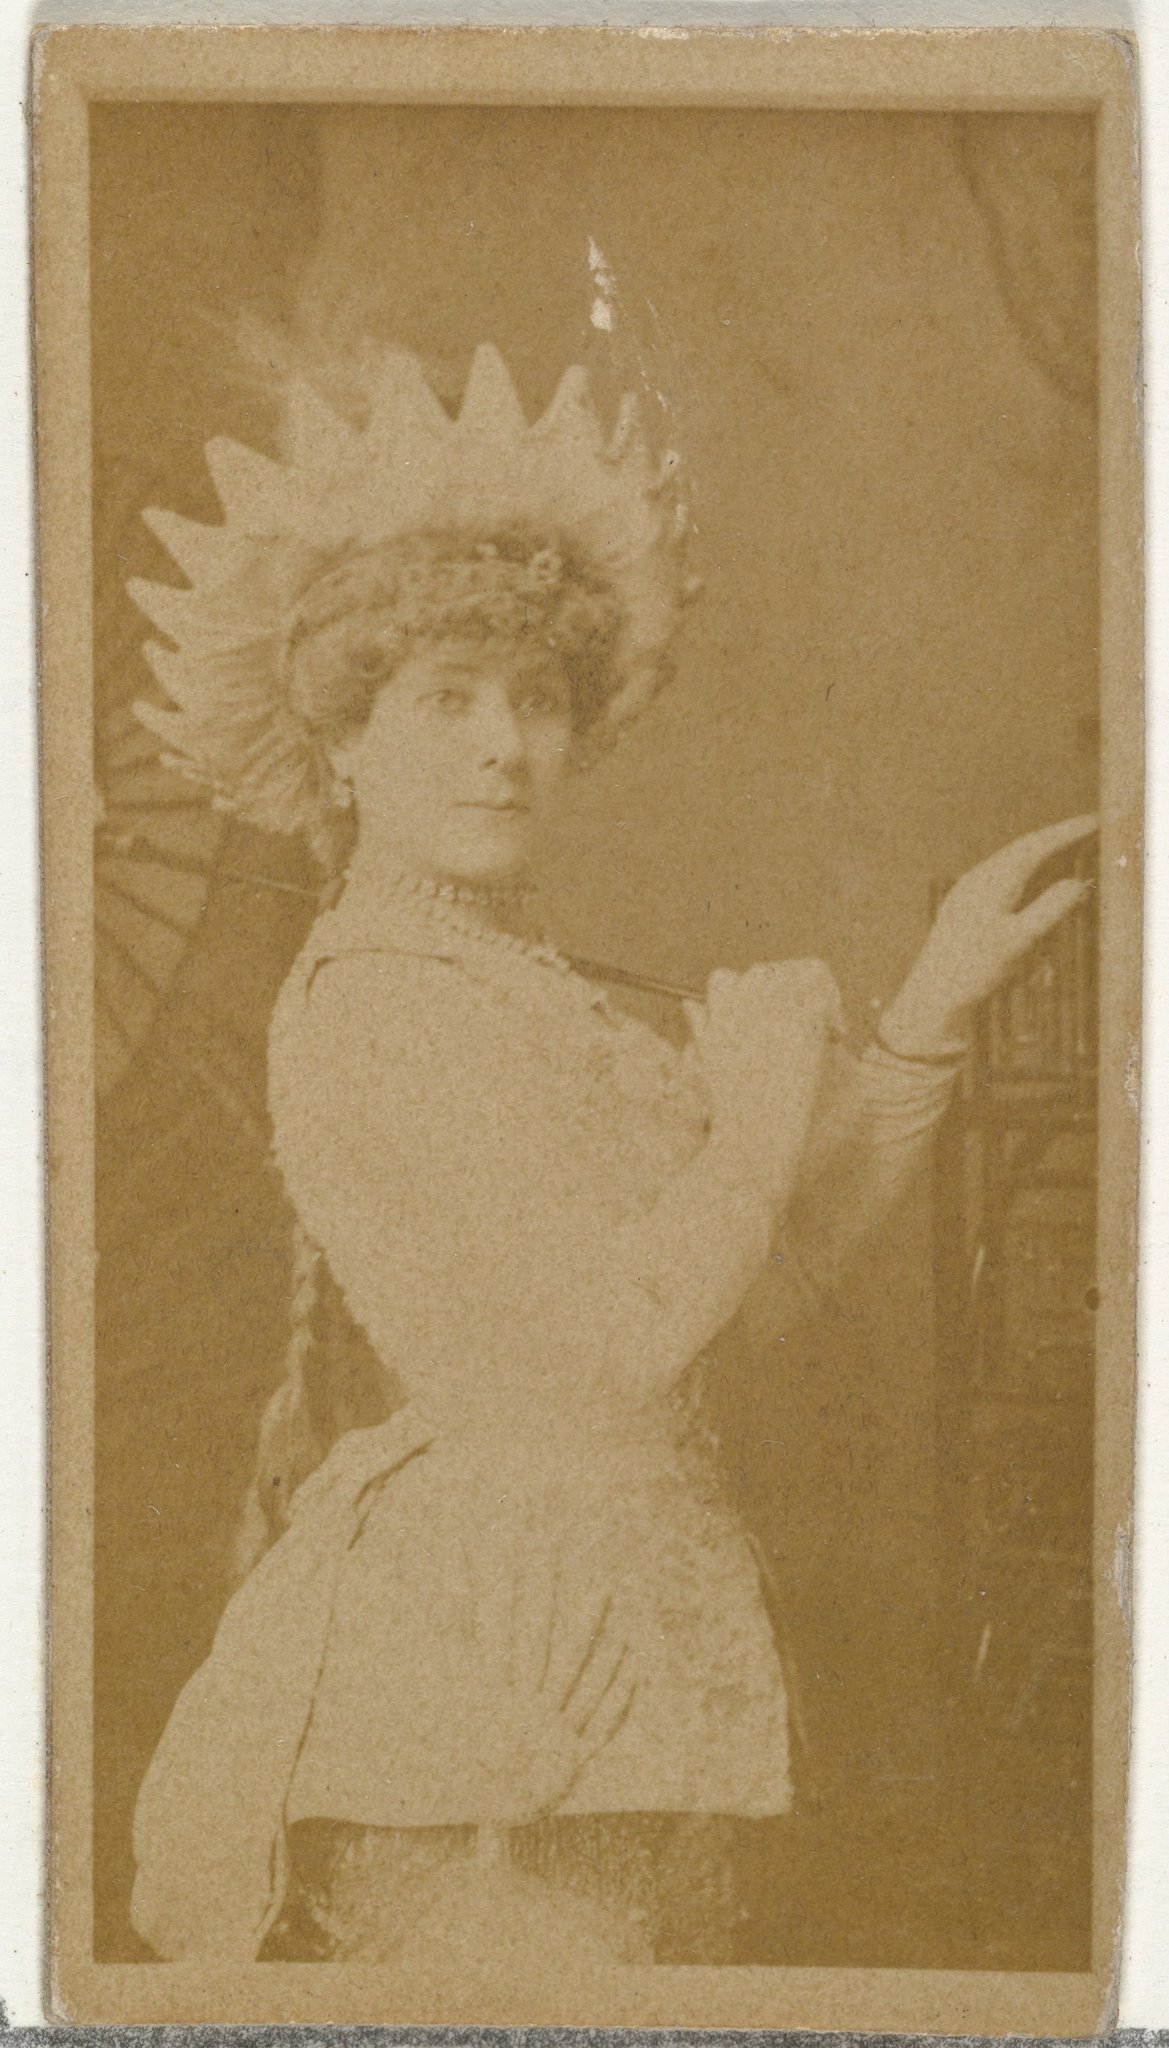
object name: photograph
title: [Actress wearing pointed hat], from the Actors and Actresses series (N145-8) issued by Duke Sons & Co. to promote Duke Cigarettes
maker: w. duke, sons & co.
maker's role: publisher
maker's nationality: american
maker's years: 1870-1920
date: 1891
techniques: albumen silver print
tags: portraits,women,actresses